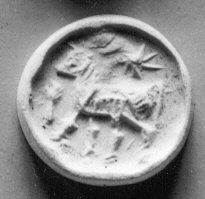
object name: stamp seal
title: Stamp seal (bifacial disk) with animals and divine symbols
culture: assyrian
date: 734-601 BCE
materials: stone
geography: mesopotamia or syria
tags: animals